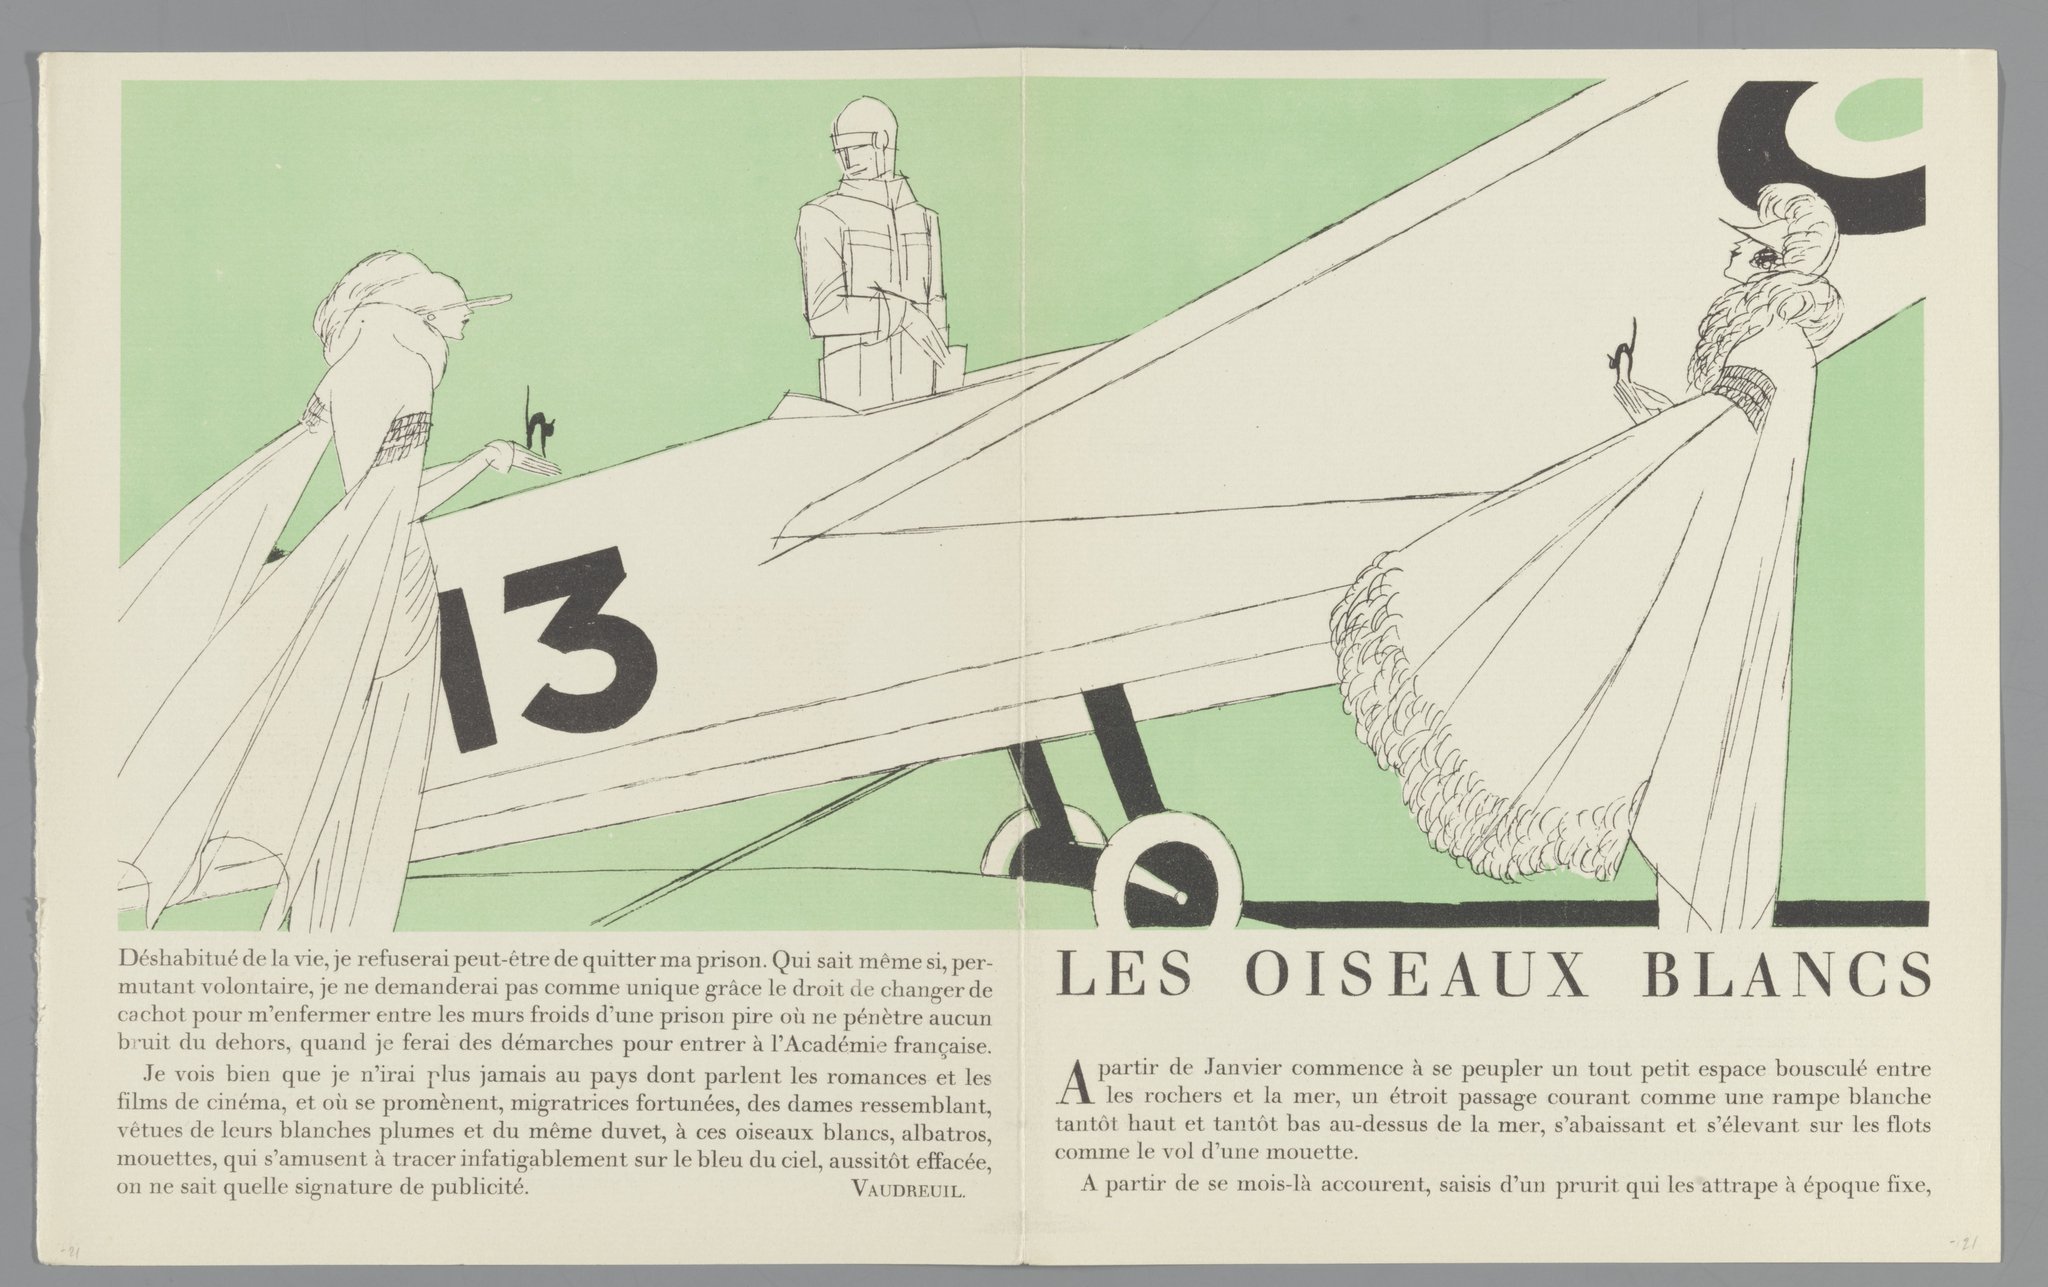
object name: fashion print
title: Gazette du Bon Ton. Art – Modes & Frivolités: Layout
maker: lucien vogel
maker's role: publisher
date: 1922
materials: paper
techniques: printing, letterpress printing, photochemical processes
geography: paris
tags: aircraft, aeroplane, fashion plates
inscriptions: date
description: The Gazette du Bon Ton was about more than just fashion. It was also a treat for the eyes for typographers and graphic designers. Texts and illustrations were arranged to form a harmonious whole. Rather daringly, large illus-trations often occupied an entire double-page spread.